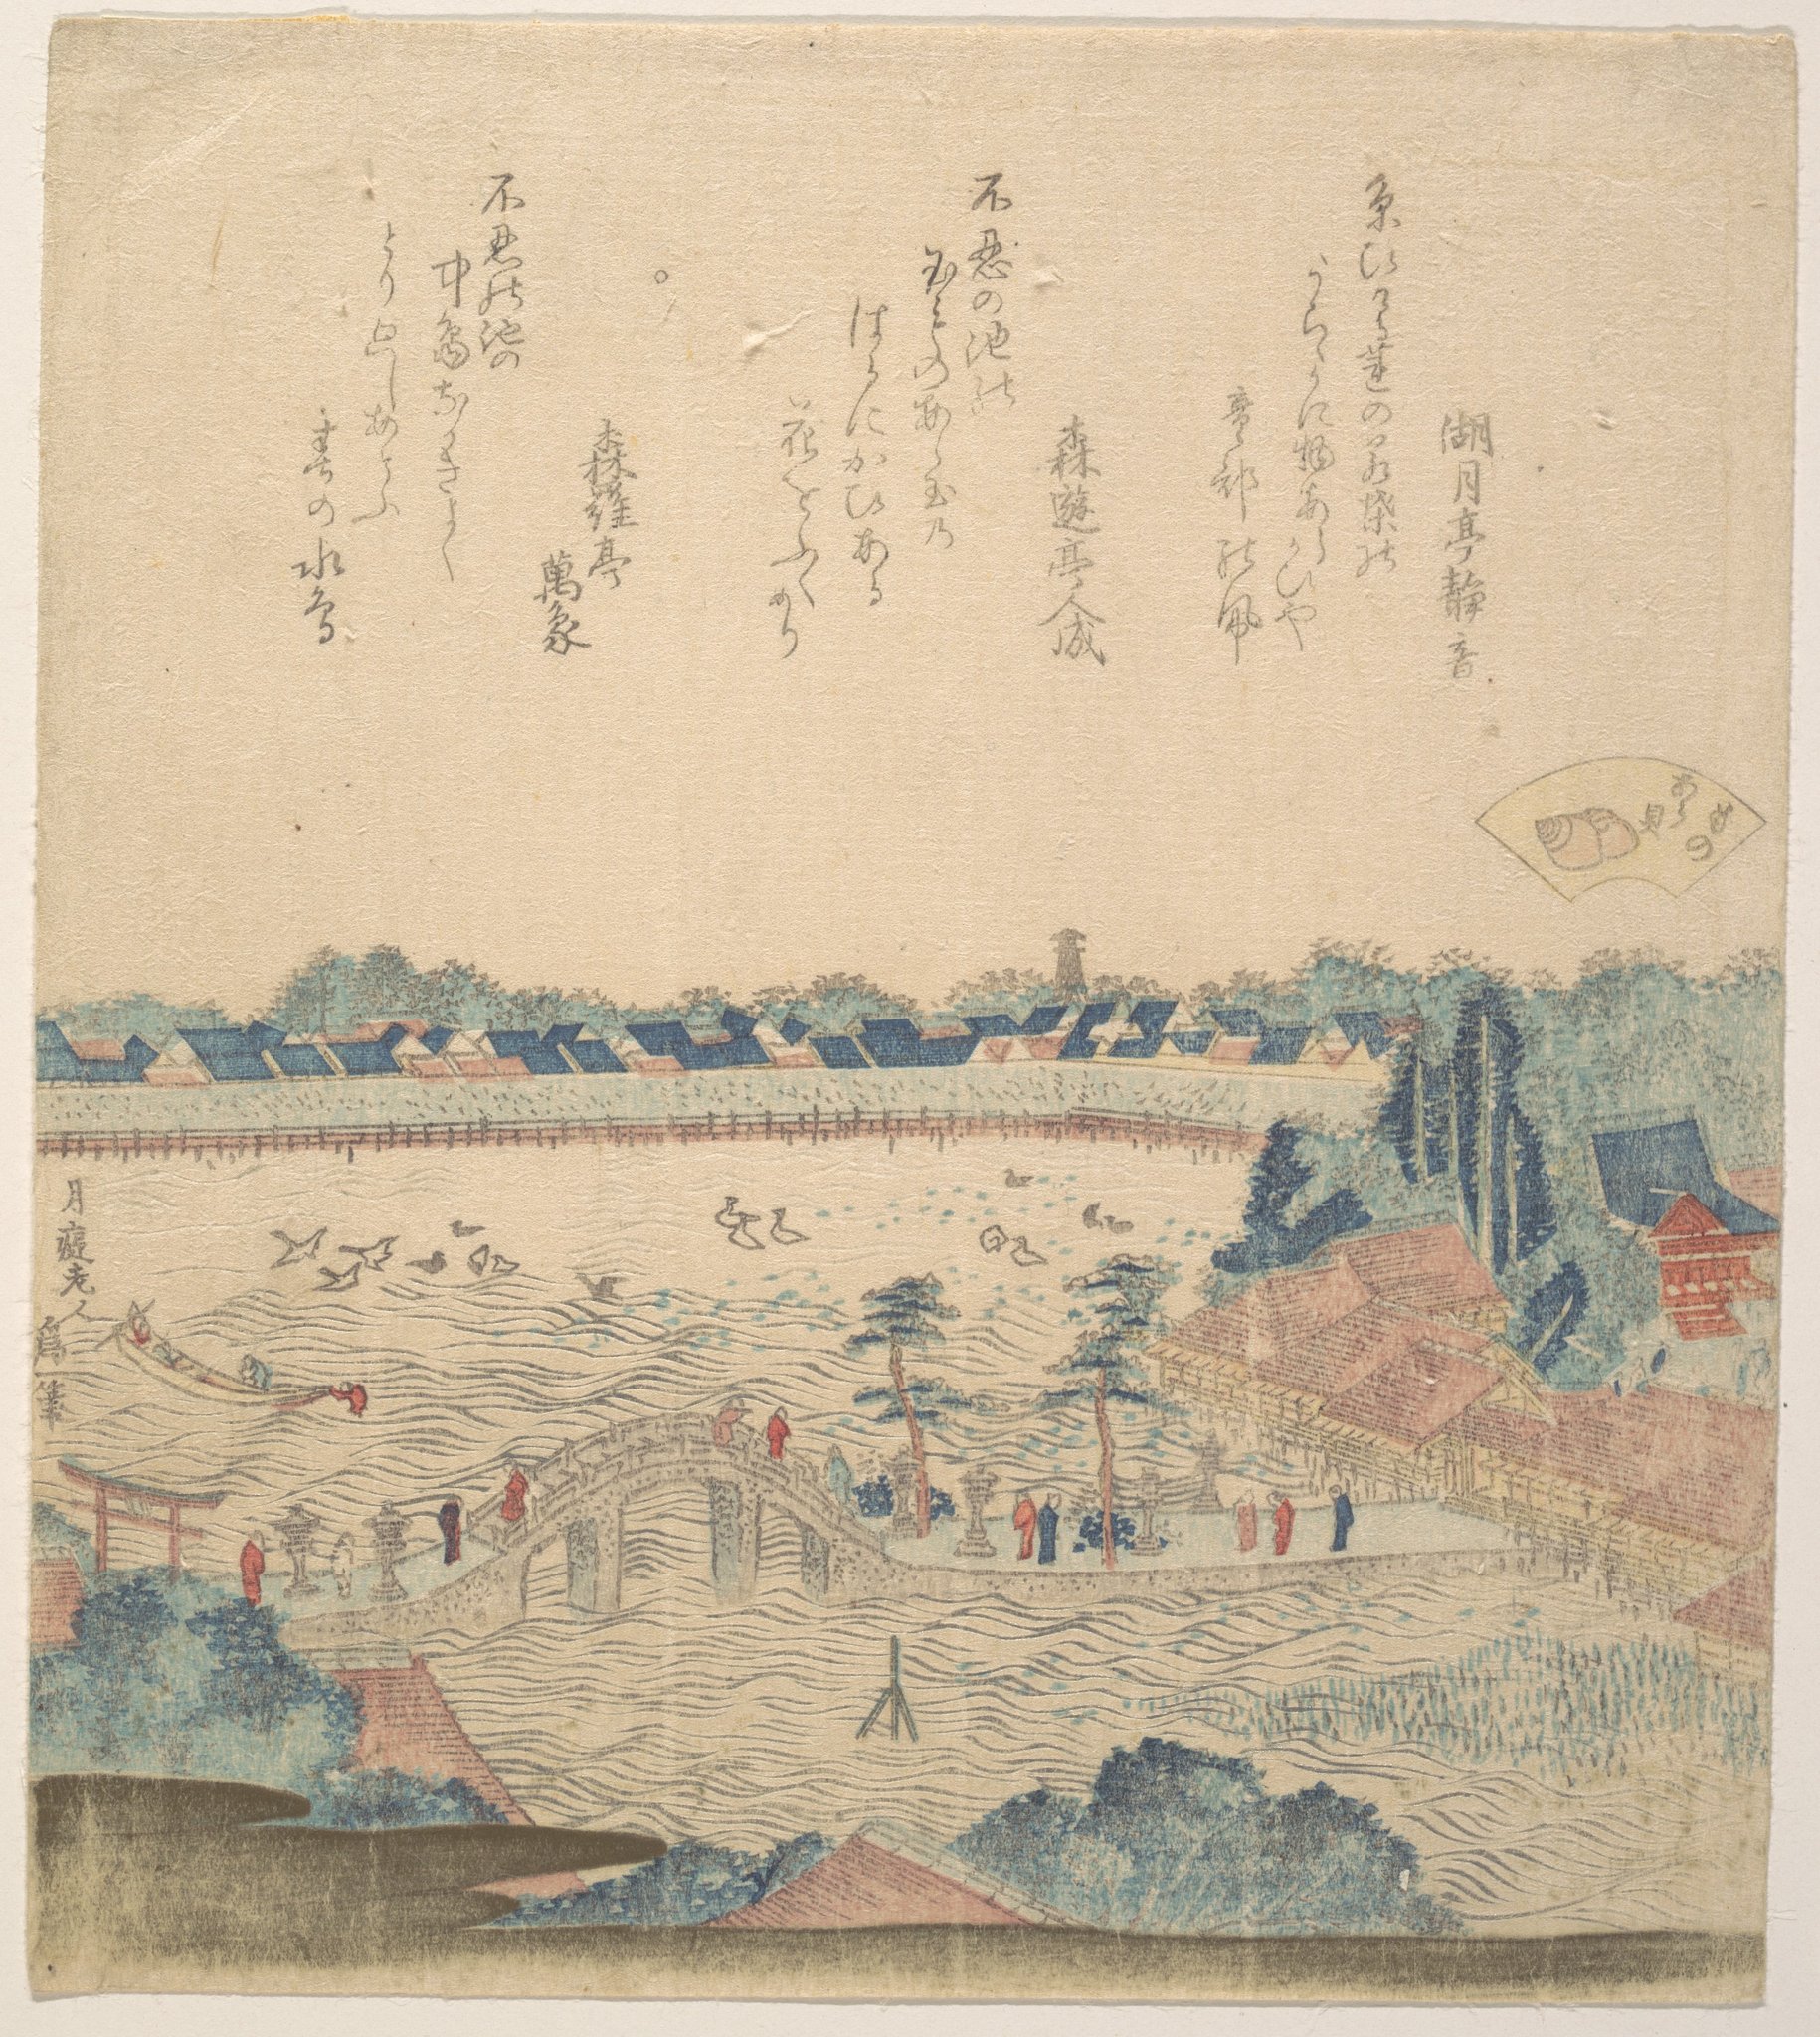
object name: print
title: Landscape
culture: japanese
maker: katsushika hokusai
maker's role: artist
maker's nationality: japanese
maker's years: 1760-1849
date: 1760-1849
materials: ink, paper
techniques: surimono, woodblock print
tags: buildings,bridges,landscapes,boats